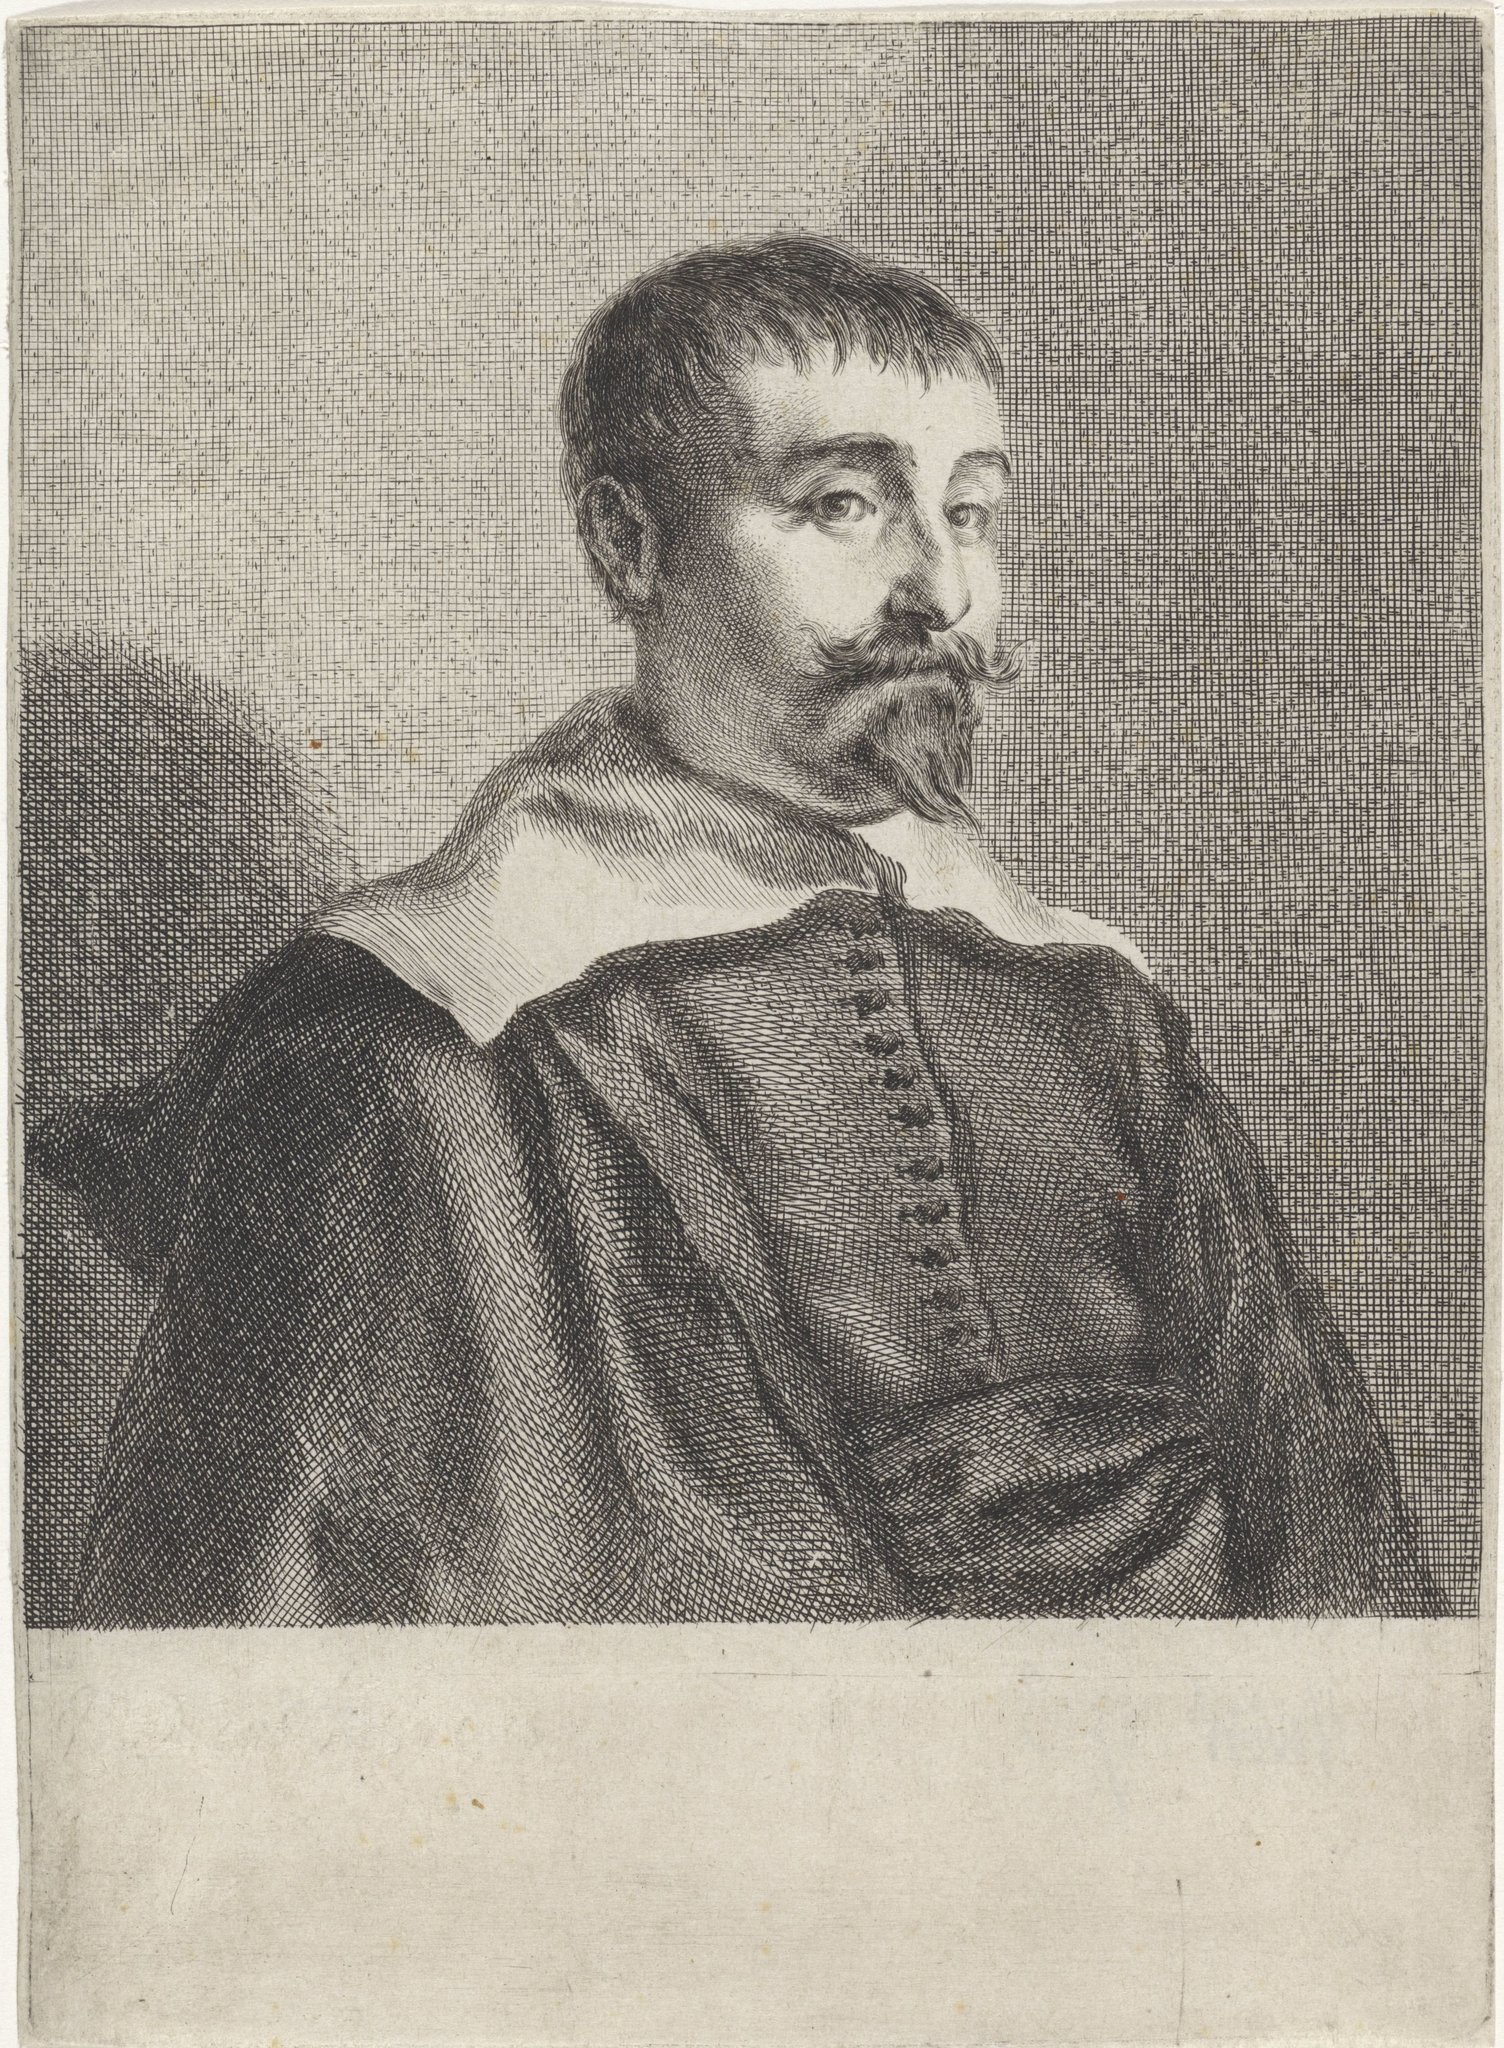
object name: print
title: Portret van een onbekende man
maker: cornelis visscher (ii)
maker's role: draughtsman, painter, print maker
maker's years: 1628-1658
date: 1638-1658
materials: paper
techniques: engraving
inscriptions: collector's mark: Lugt 2228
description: Portret van een onbekende man met korte haren en kinbaard, een platte kraag en een mantel over de rechterschouder. Hij draagt een wanbuis met twaalf knoopjes.